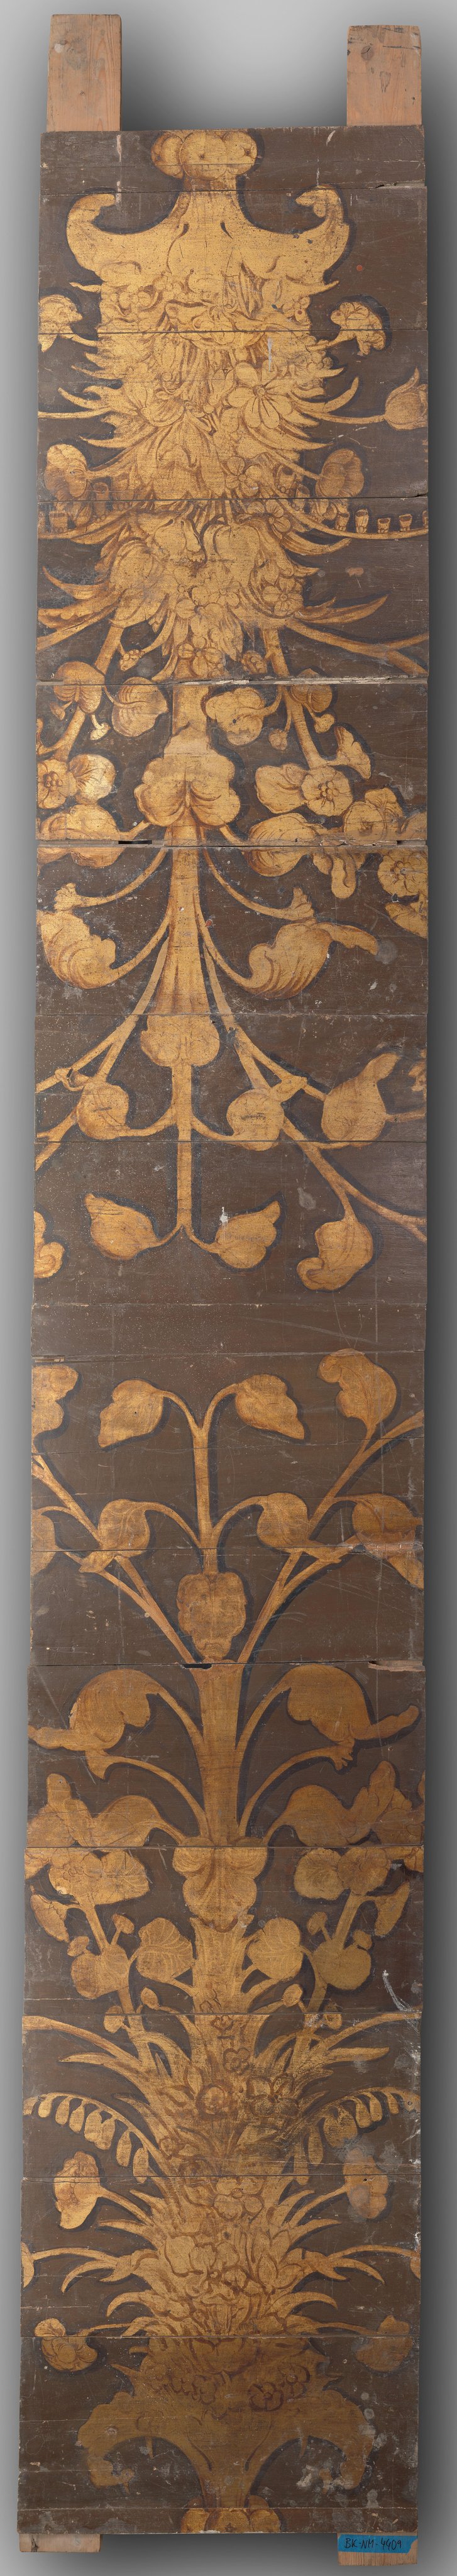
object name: architectural element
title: Tongewelf, samengesteld uit eiken planken, beschilderd met grotesken en acanthusranken, afgewende vrouwenfiguren met onderlijven die eindigen in klauwen en voluten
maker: Anonymous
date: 1600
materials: wood, paint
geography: northern netherlands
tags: the hague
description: In 1878 was het stadhouderlijk kwartier 'hersteld'. De heer F.J. Nieuwenhuis, architect te Utrecht, was belast met de verbouw van de eerste kamer.